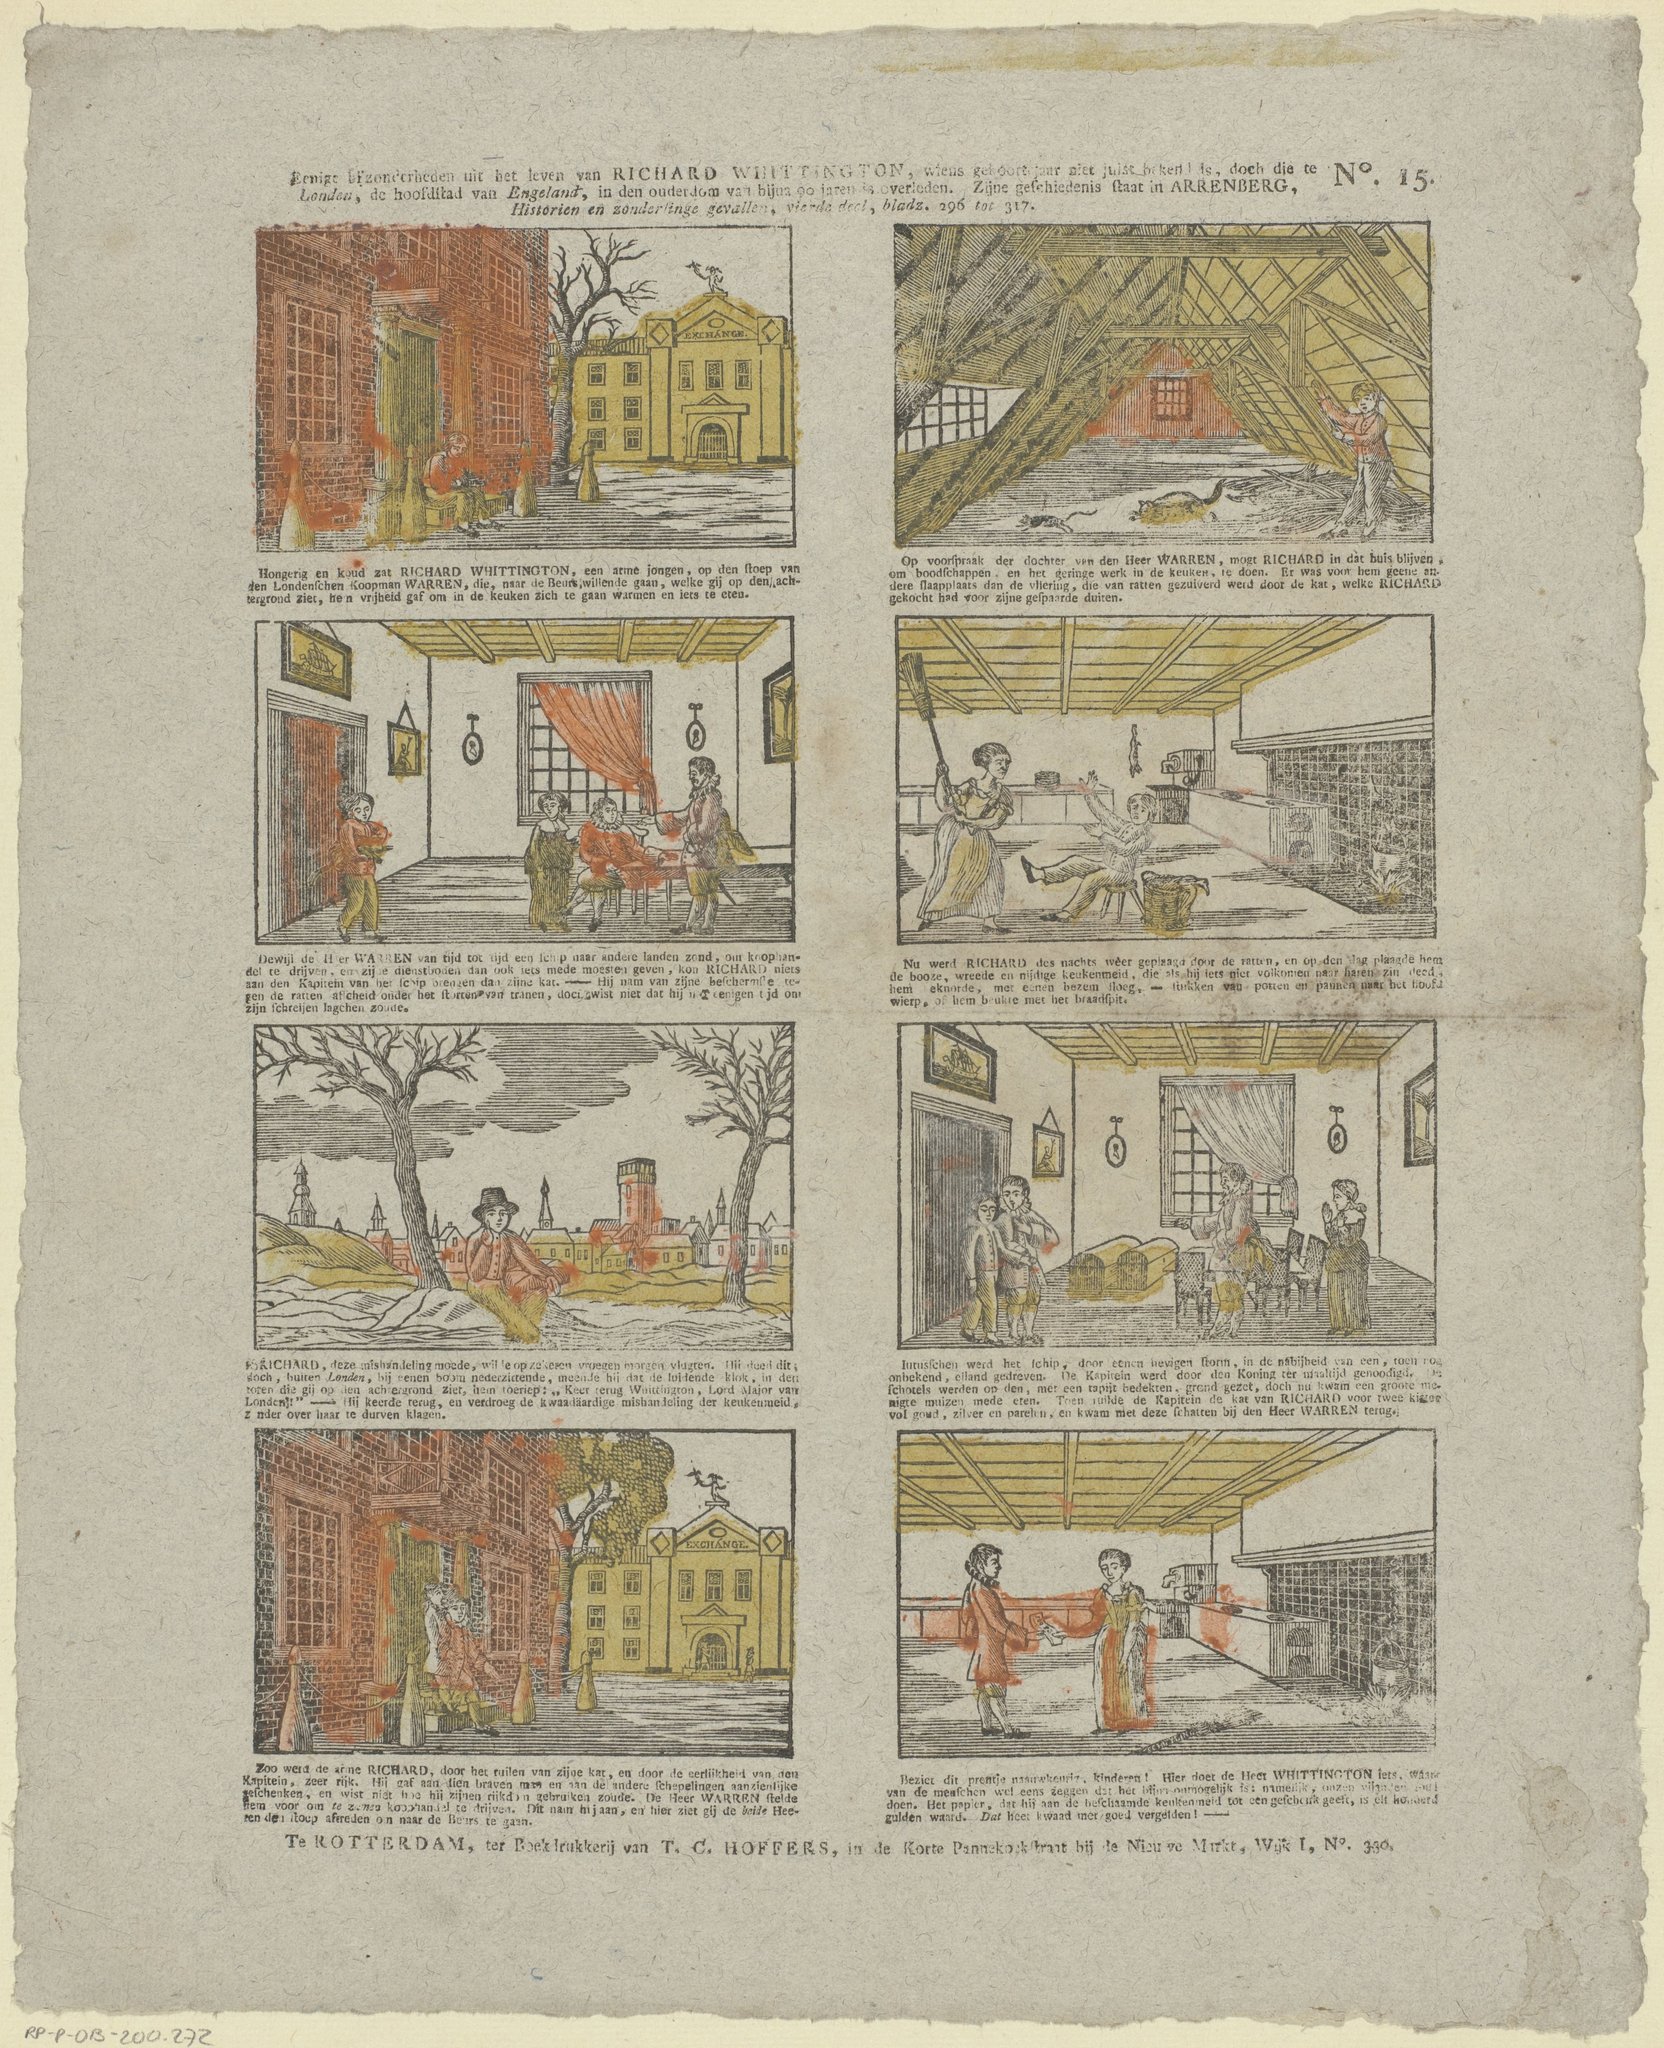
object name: print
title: Eenige bijzonderheden uit het leven van Richard Whittington, wiens geboortejaar niet juist bekend is (...).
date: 1820-1848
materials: paper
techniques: colour, letterpress printing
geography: rotterdam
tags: cat, tales and fairy tales, orphans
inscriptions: collector's mark: Lugt 2760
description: Blad met 8 voorstellingen uit het leven van Richard Whittington. De arme weesjongen Whittington verruild zijn kat voor twee kisten vol goud, zilver en parels. Onder elke afbeelding een onderschrift. Genummerd rechtsboven: No. 15.